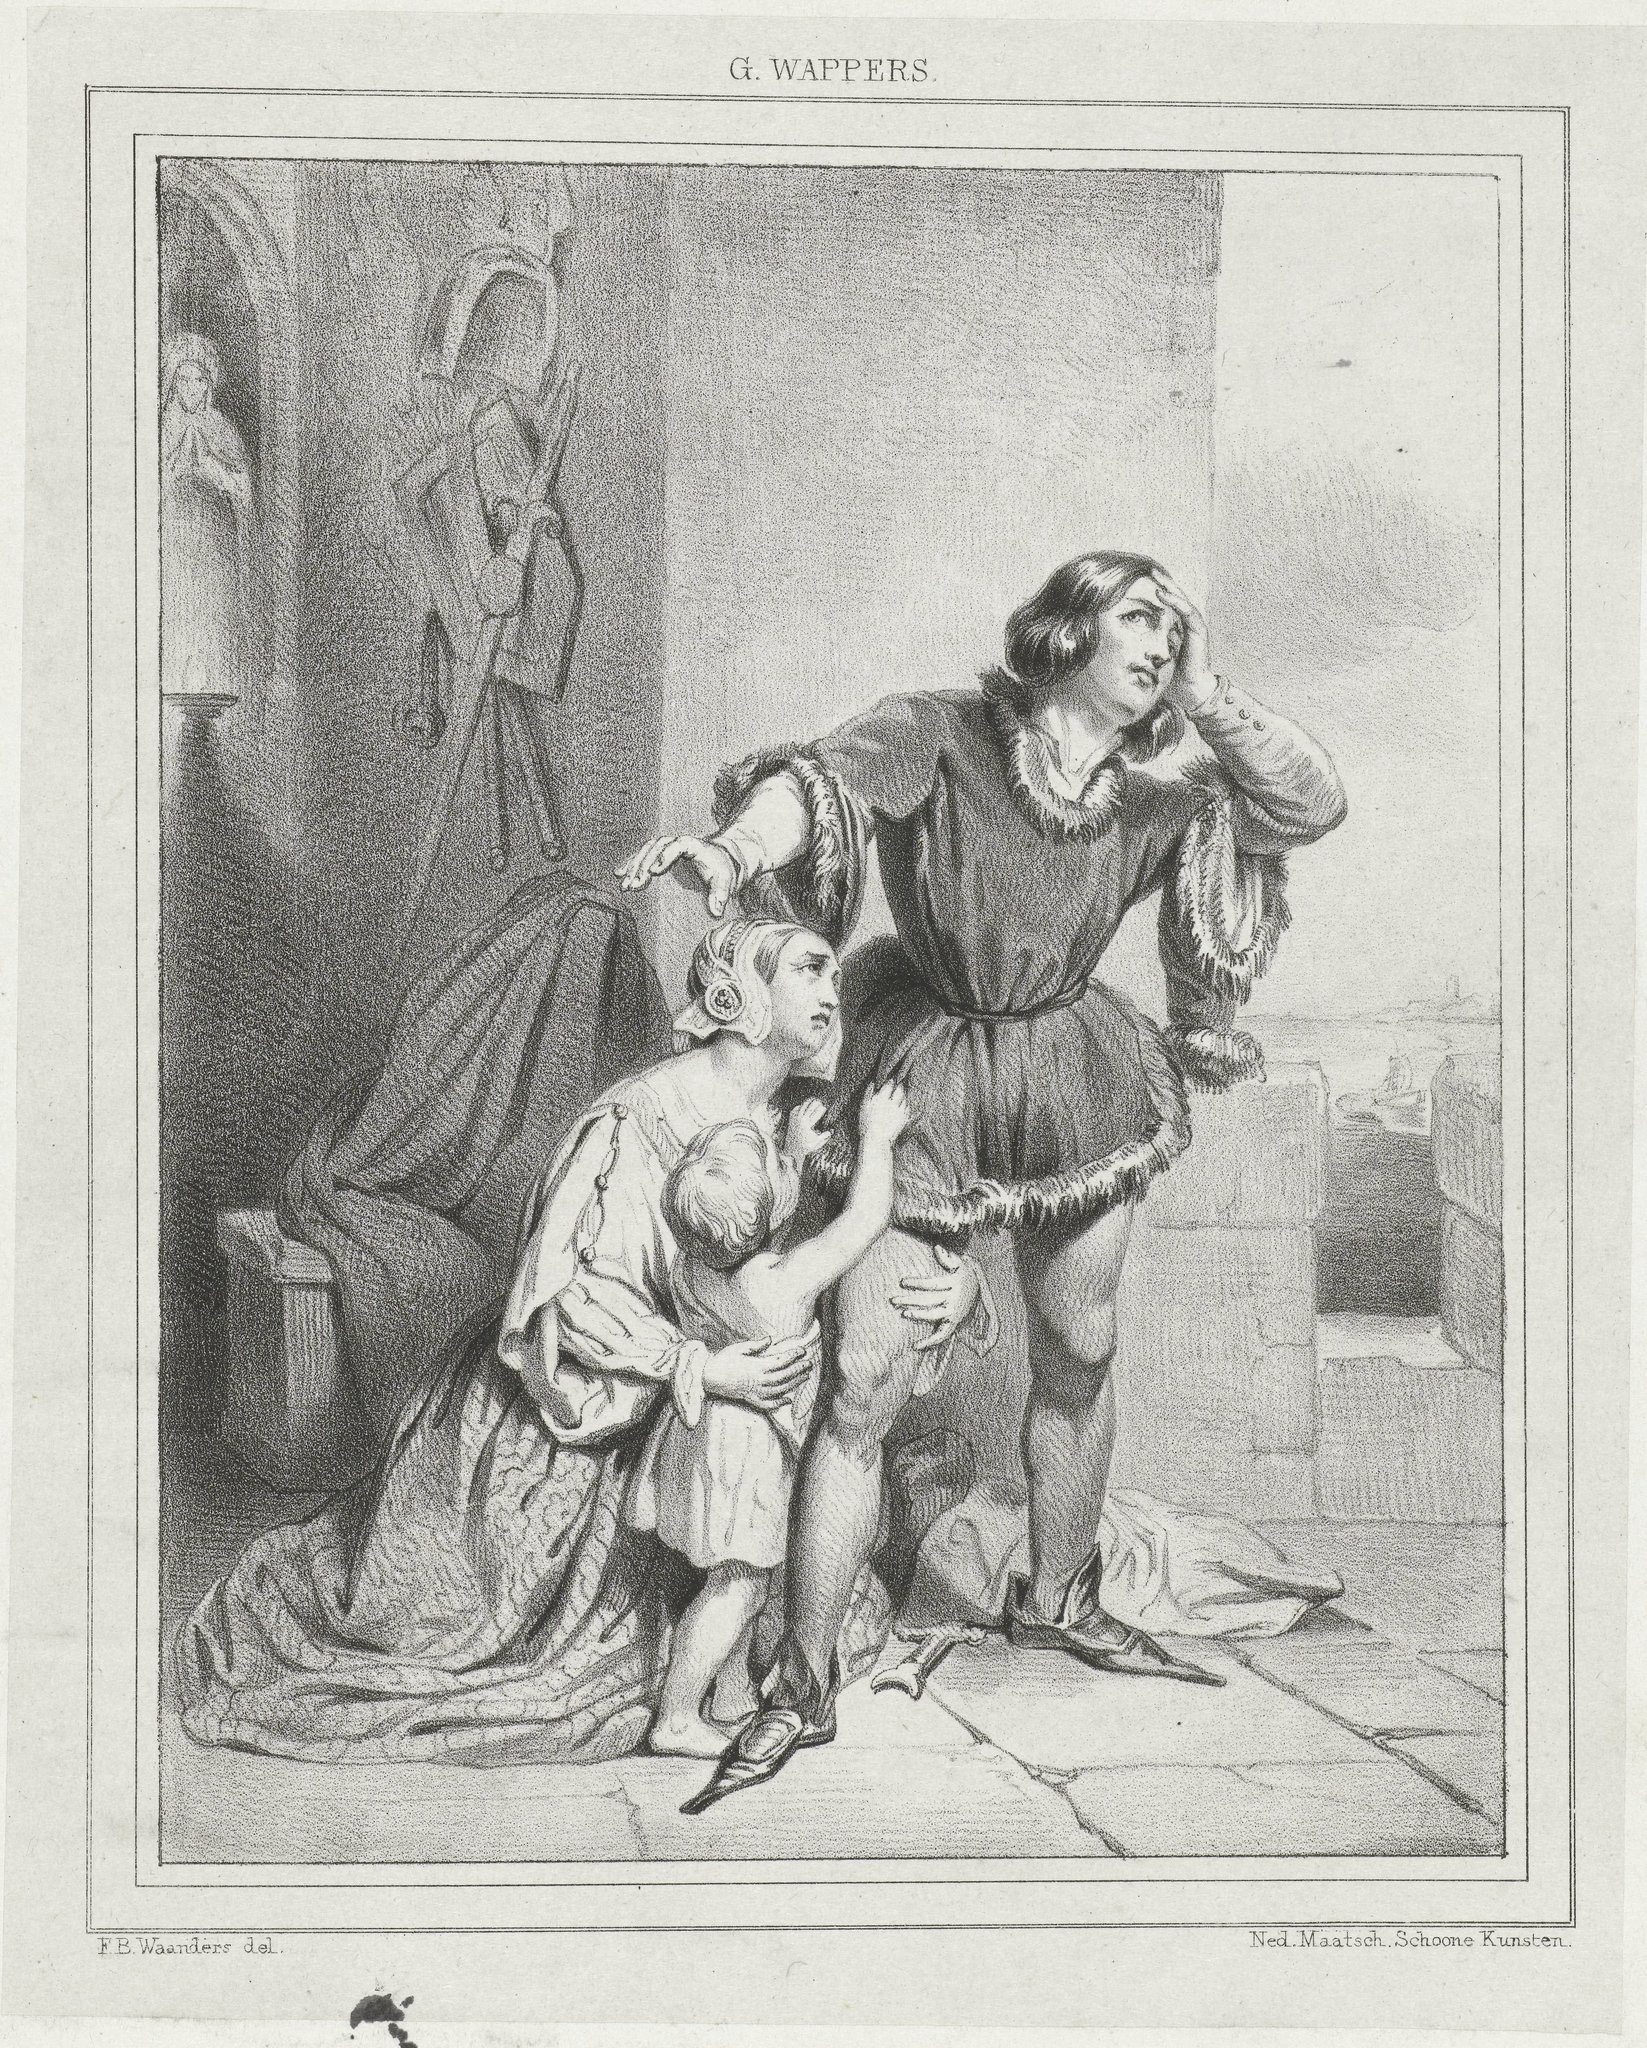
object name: print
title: Albrecht Beiling neemt afscheid van vrouw en kind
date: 1840-1841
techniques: printmaking, lithograph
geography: netherlands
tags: self-sacrifice, death in the service of a higher purpose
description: Albrecht Beiling neemt afscheid van vrouw en kind, voordat hij in 1425 levend wordt begraven.